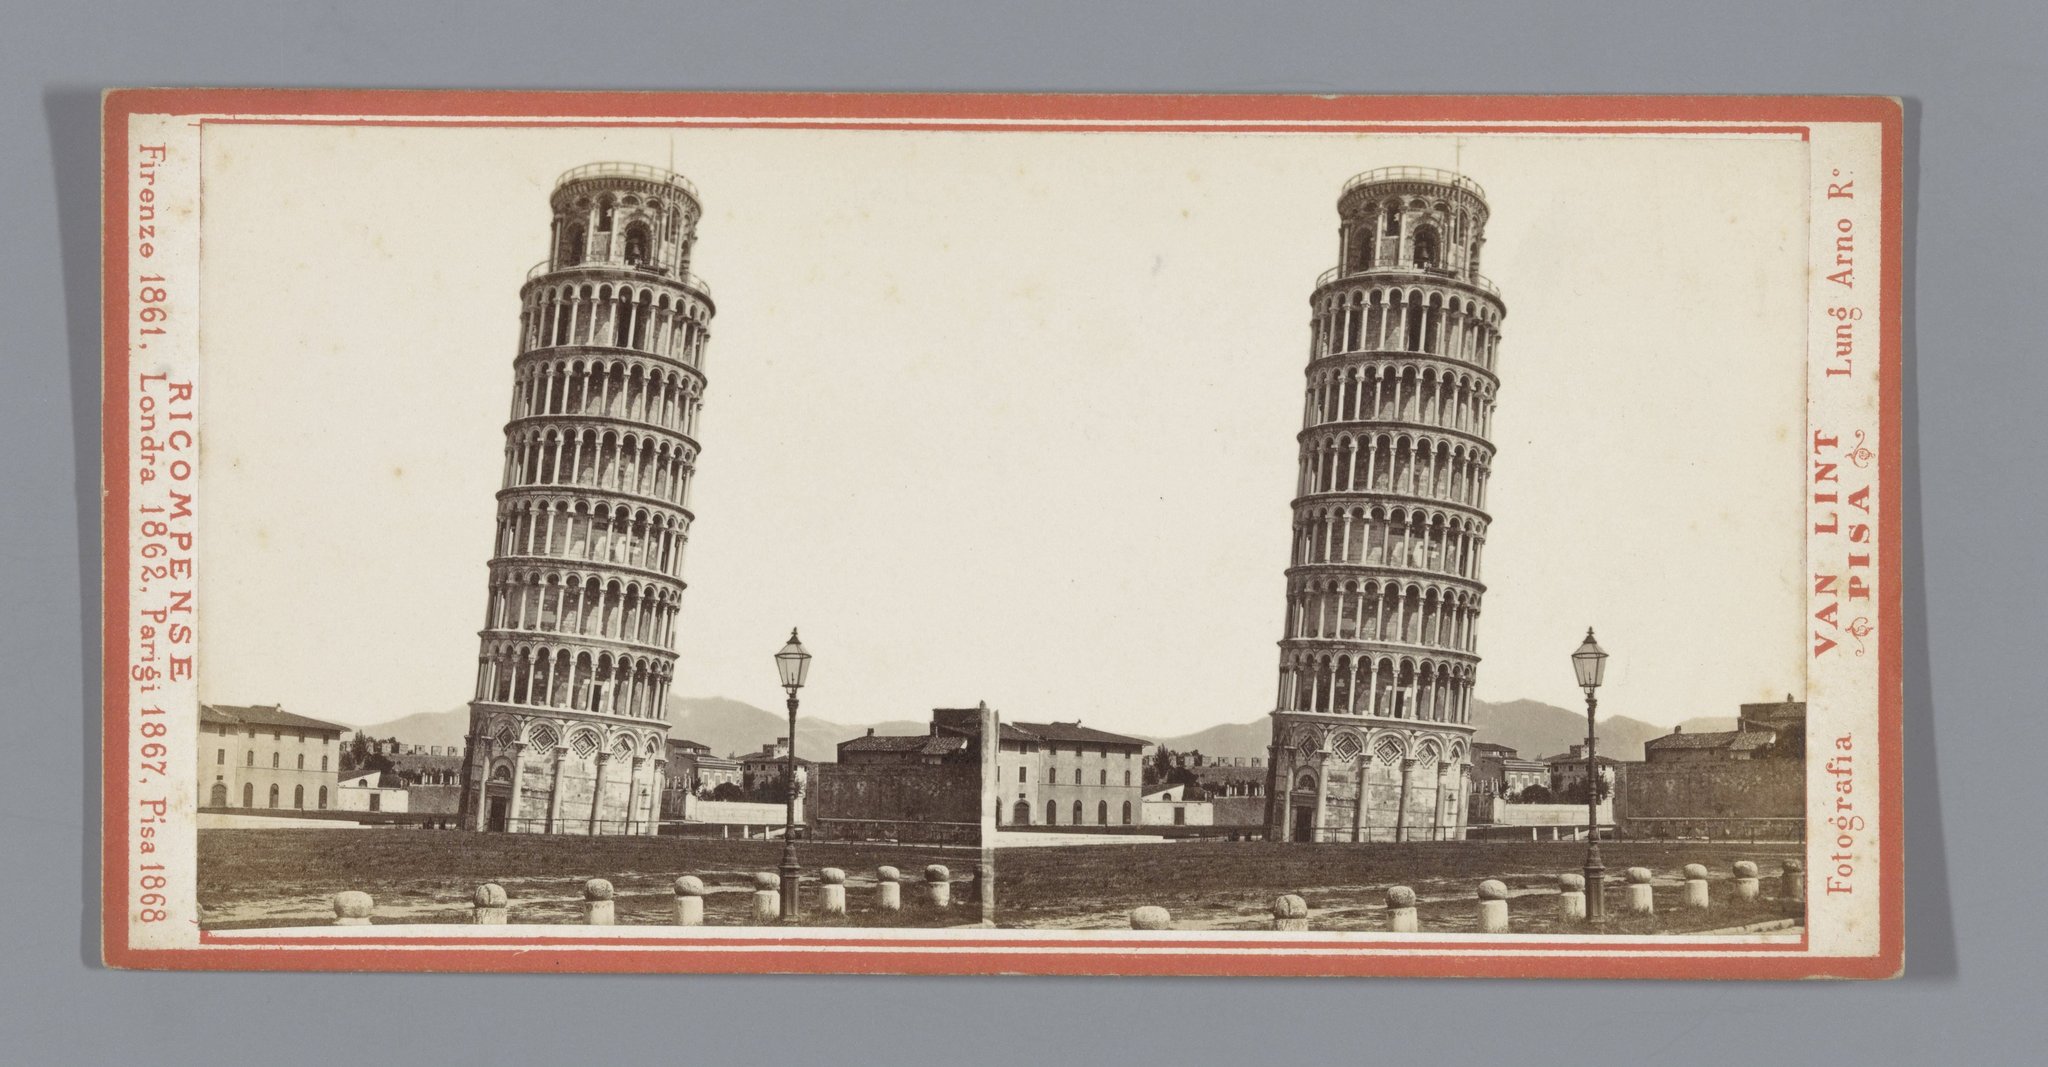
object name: stereograph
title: Exterieur van de Toren van Pisa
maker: enrico van lint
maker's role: fotograaf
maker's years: 1808-1884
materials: cardboard, photographic support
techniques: albumen print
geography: pisa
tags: parts of church exterior and annexes: campanile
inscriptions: inscription: ‘Pisa’, name: ‘Fotografia VAN LINT PISA Lung Arno Ro. RICOMPENSE Firenze 1861, Londra 1862, Parigi 1867, Pisa 1868’